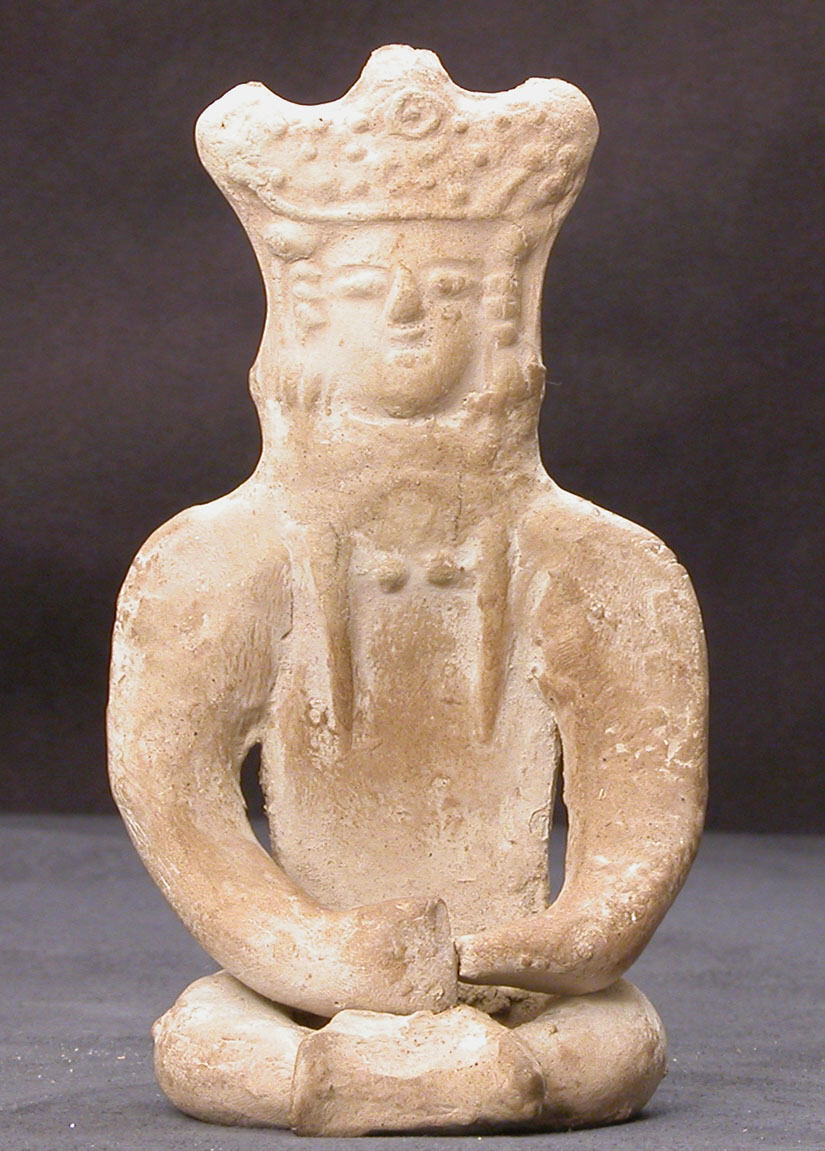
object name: figure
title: Figurine of a Female (?) Seated Personage with Elaborate Headdress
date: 1101-1300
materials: earthenware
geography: iran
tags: men